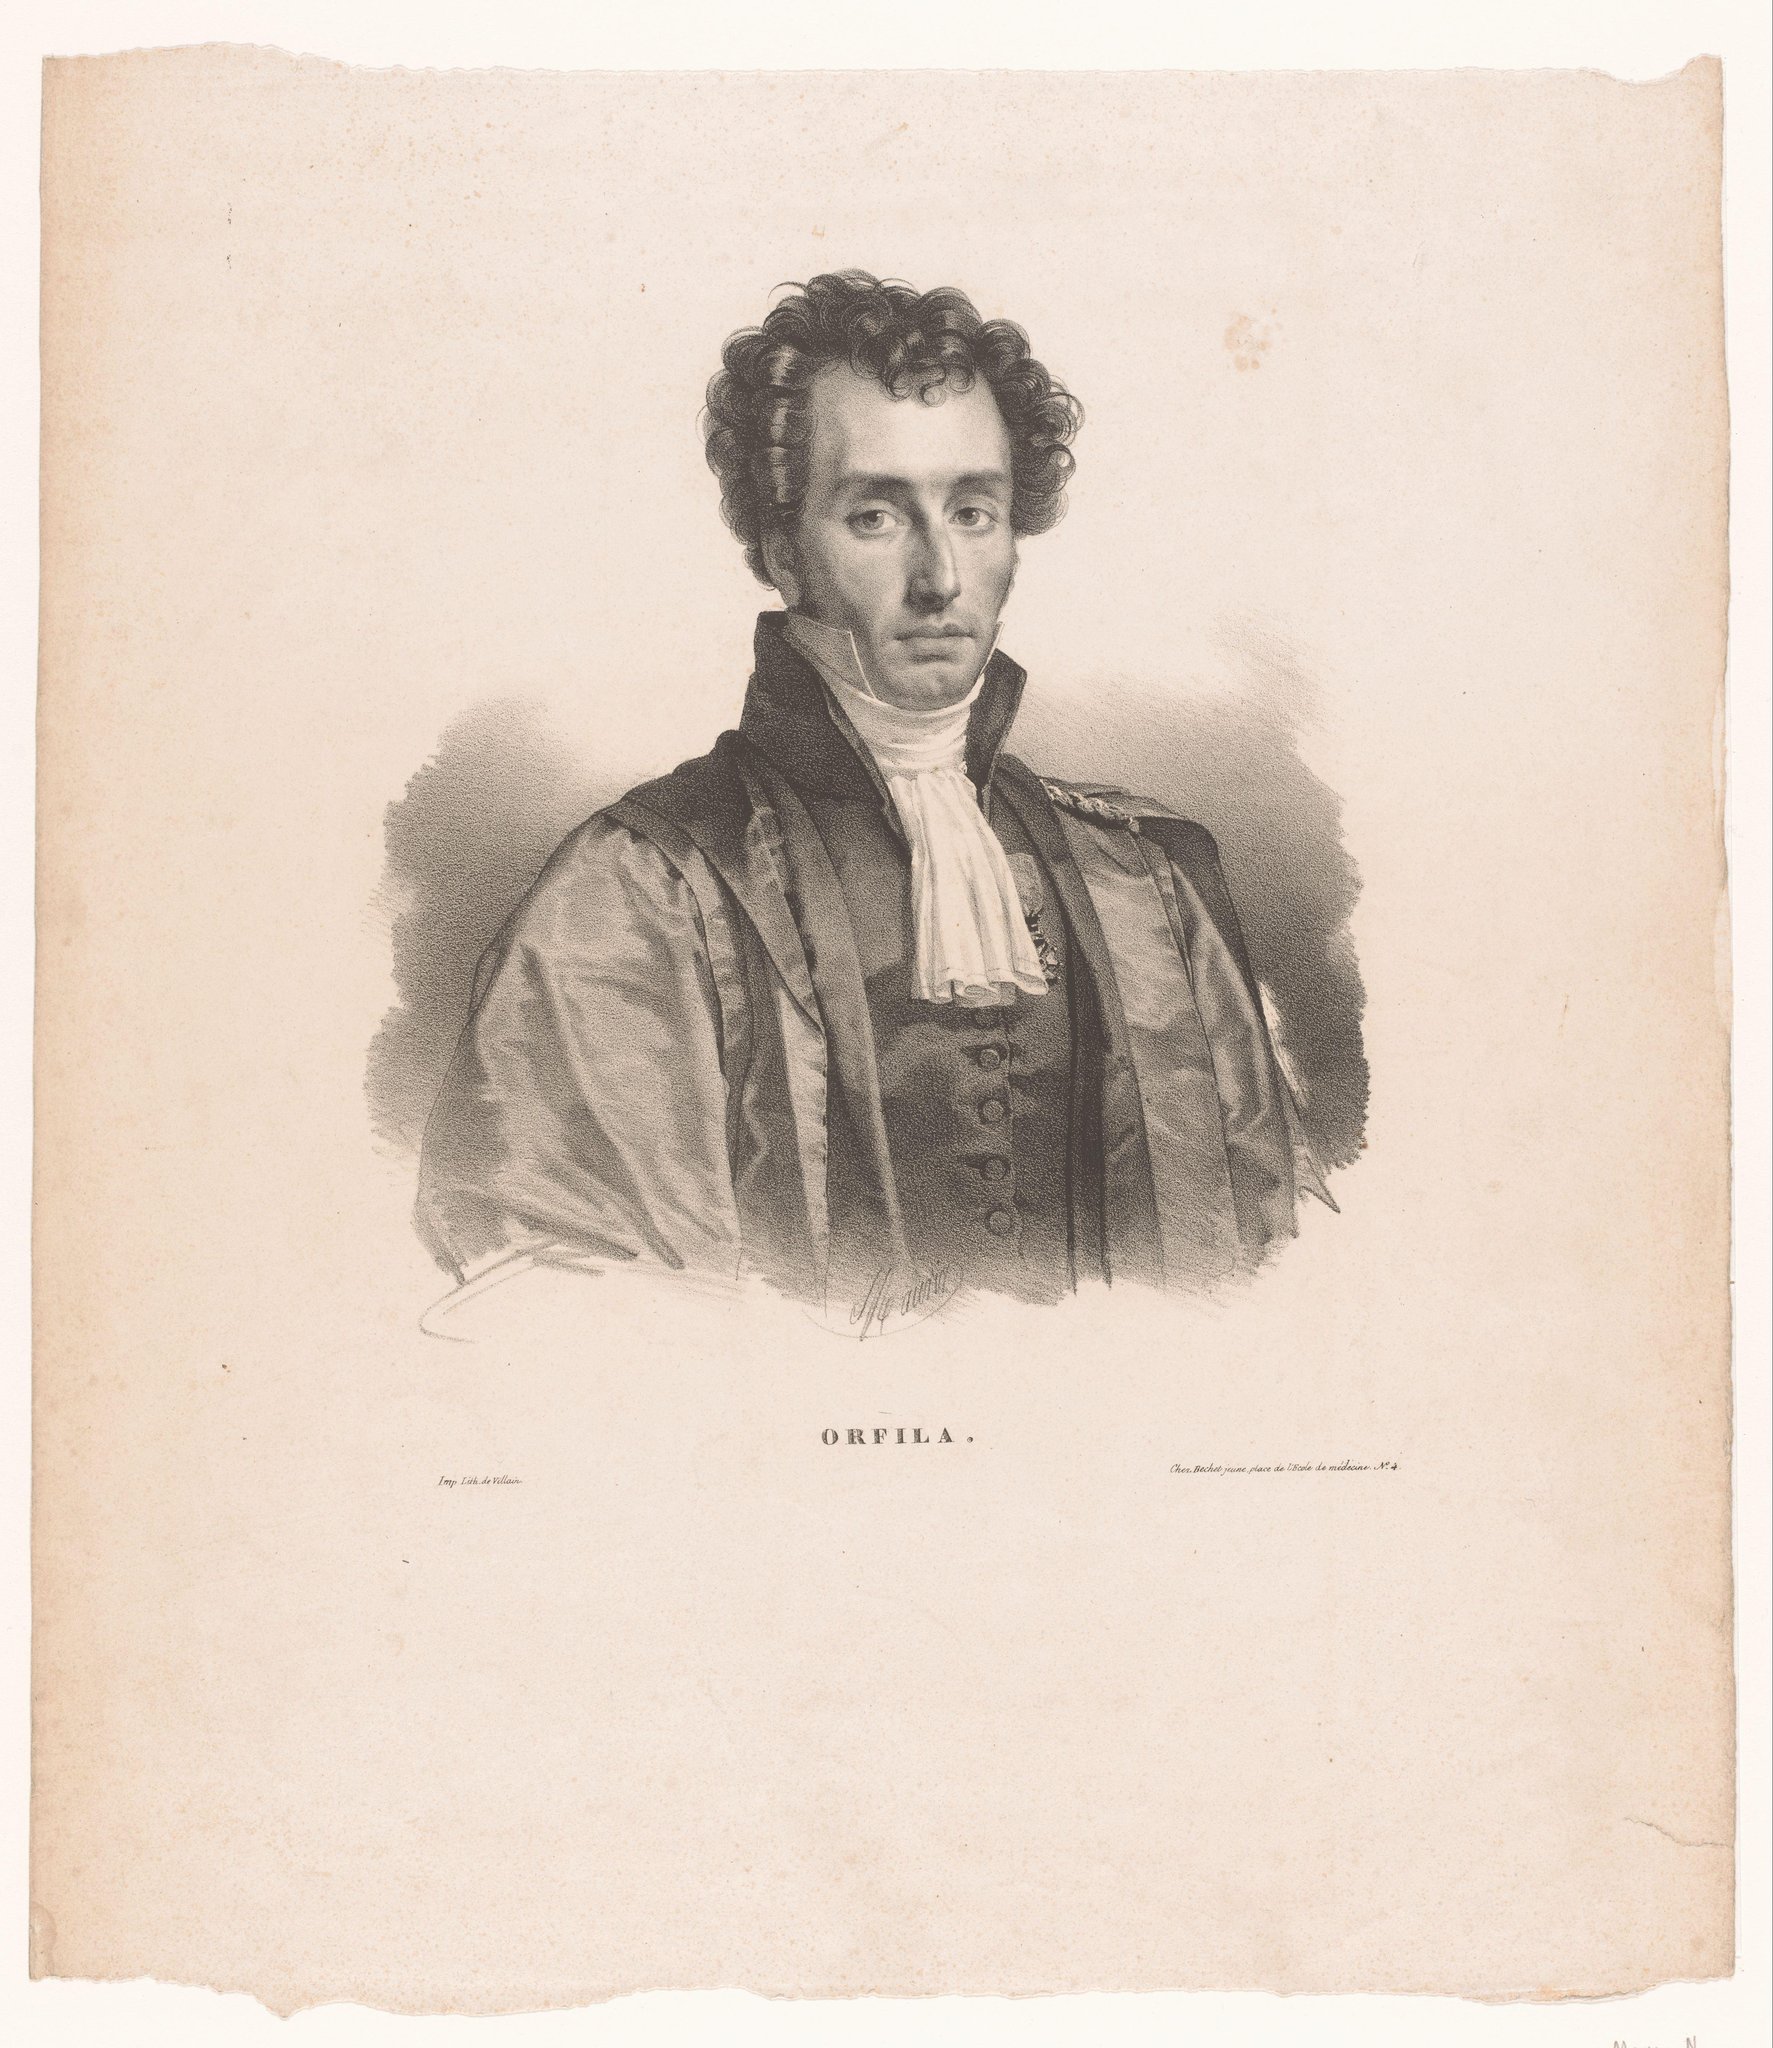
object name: print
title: Orfila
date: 1826-1852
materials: paper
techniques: lithograph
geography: paris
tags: historical persons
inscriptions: collector's mark: Lugt 2228